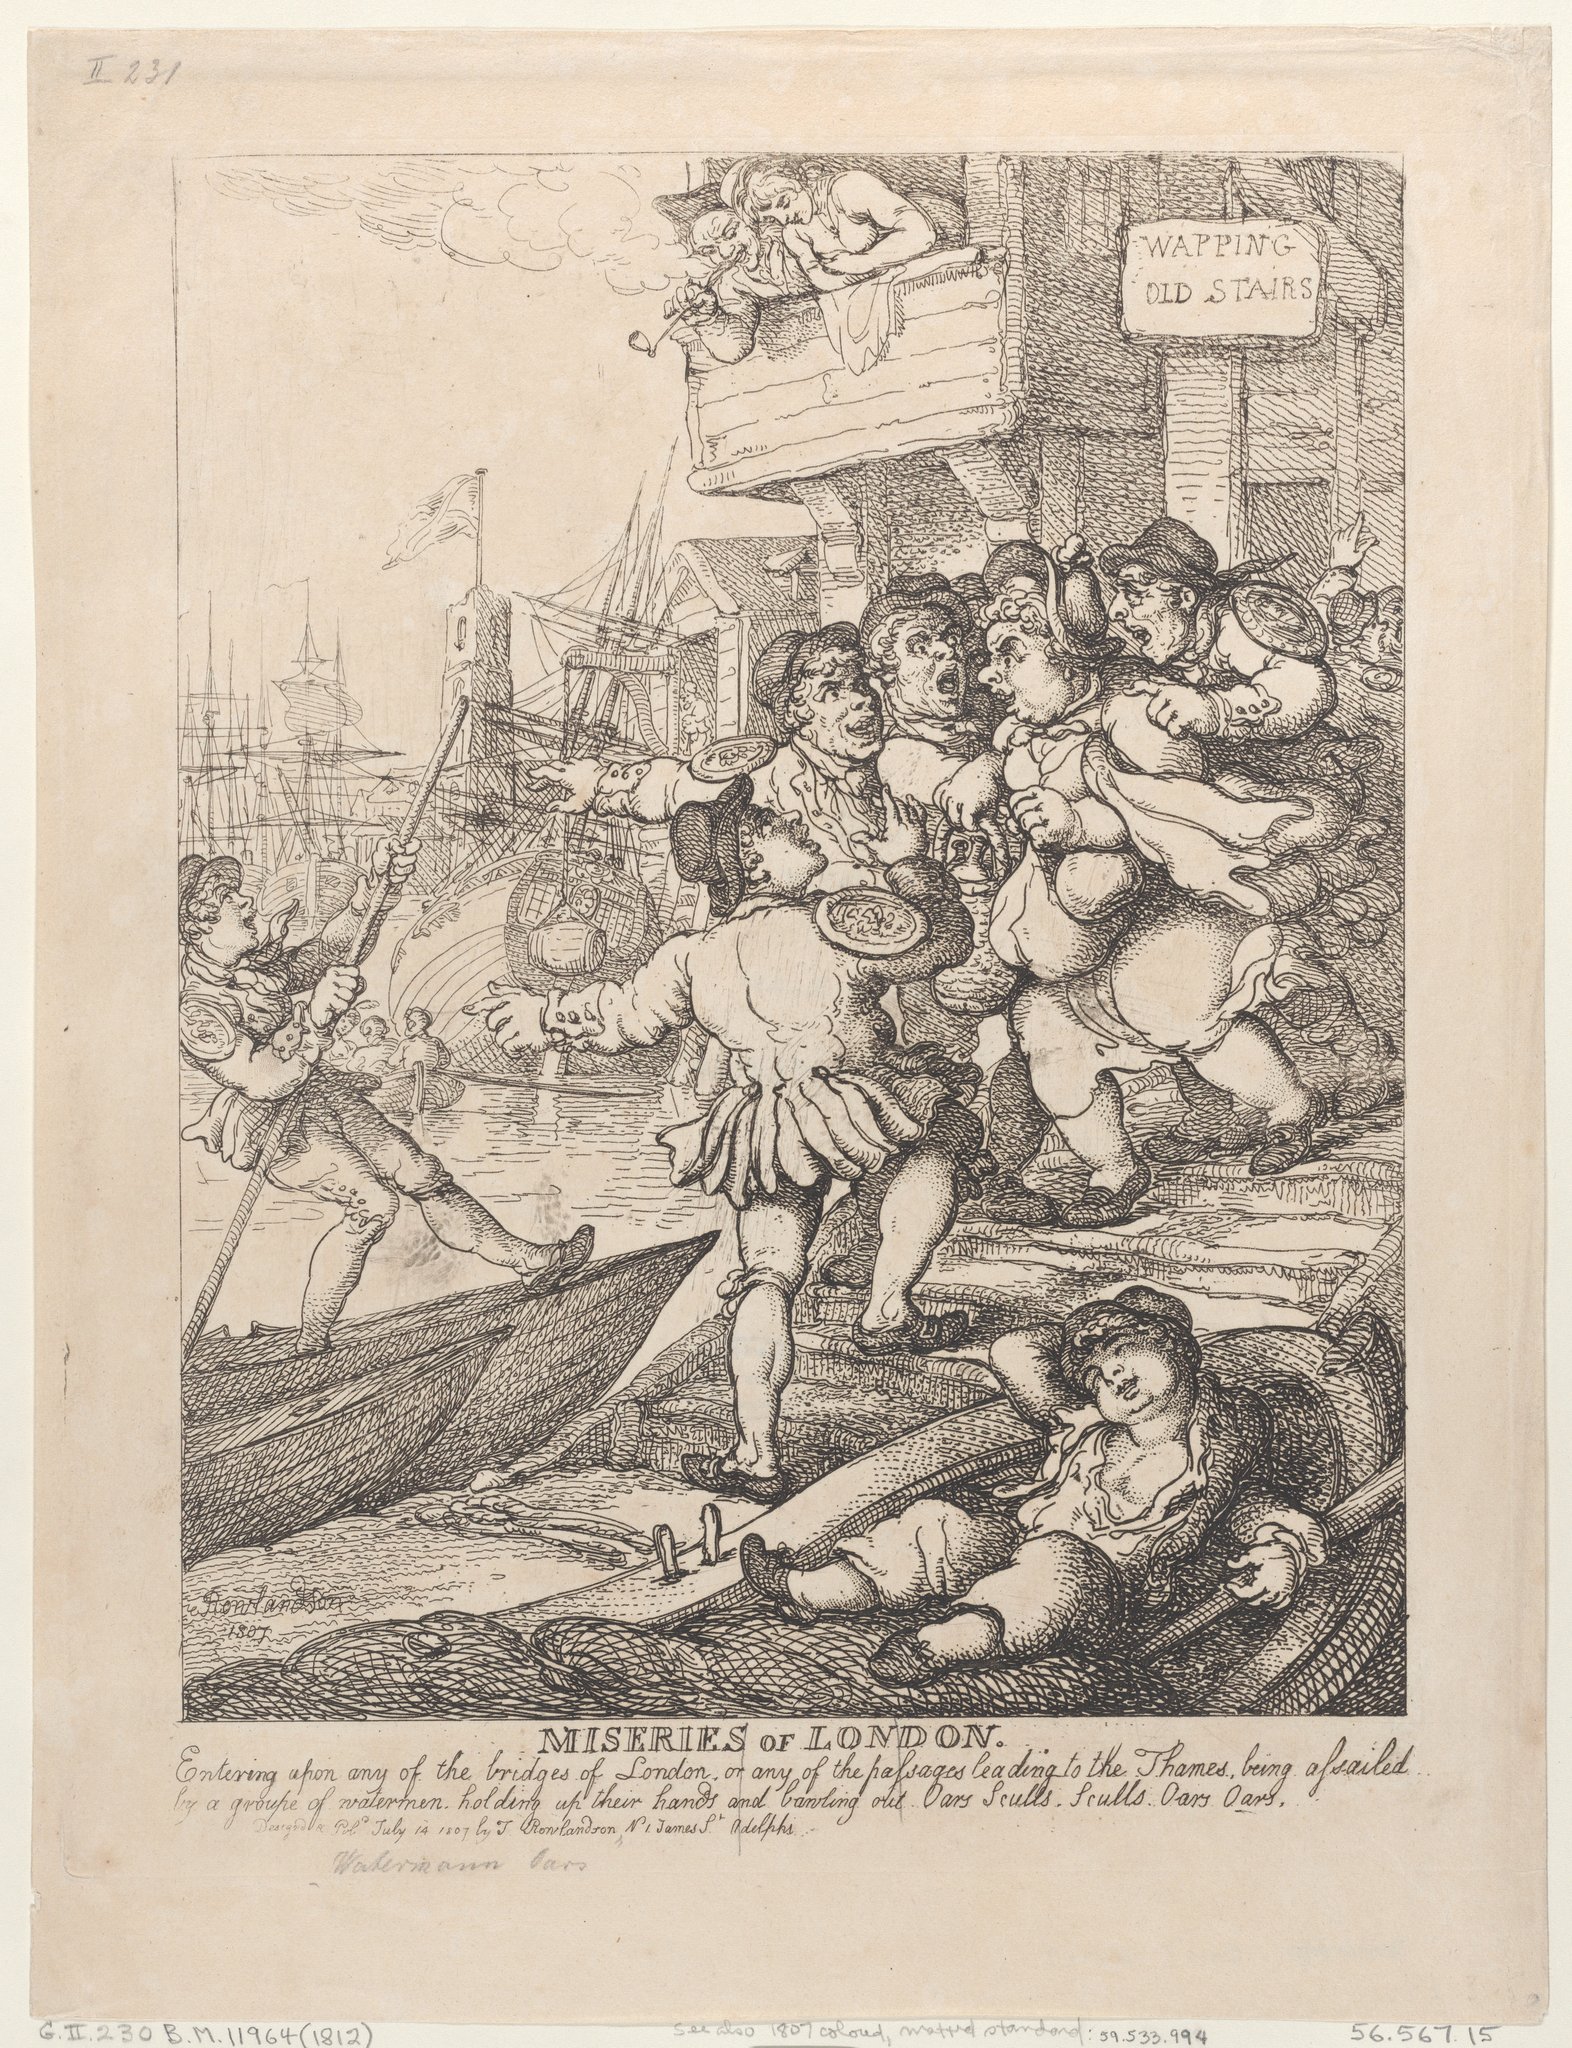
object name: print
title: Miseries of London: Entering upon any of the bridges of London or any of the passages leading to the Thames being assailed by a group of watermen holding up their hands and bawling out. Oars Sculls. Sculls. Oars. Oars.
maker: thomas rowlandson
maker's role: artist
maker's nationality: british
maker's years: 1757-1827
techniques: etching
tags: satire,men,boats,london